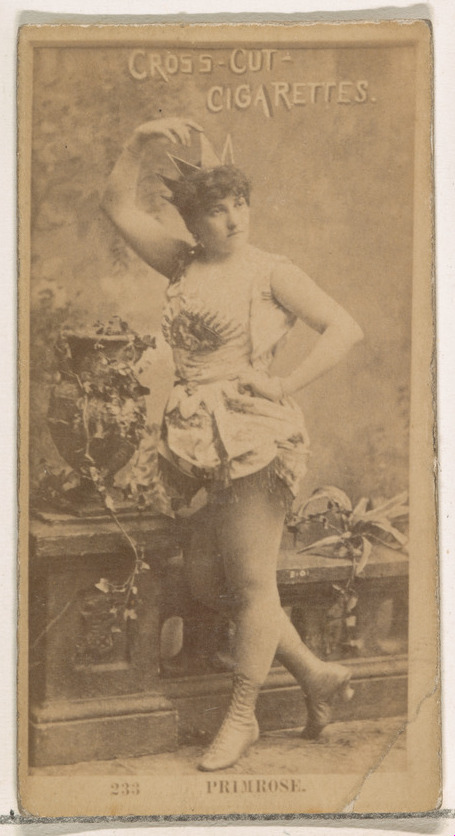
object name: print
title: Card Number 233, Clara Primrose, from the Actors and Actresses series (N145-2) issued by Duke Sons & Co. to promote Cross Cut Cigarettes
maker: w. duke, sons & co.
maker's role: publisher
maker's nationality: american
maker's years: 1870-1920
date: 1880-1889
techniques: albumen silver print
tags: portraits,women,actresses